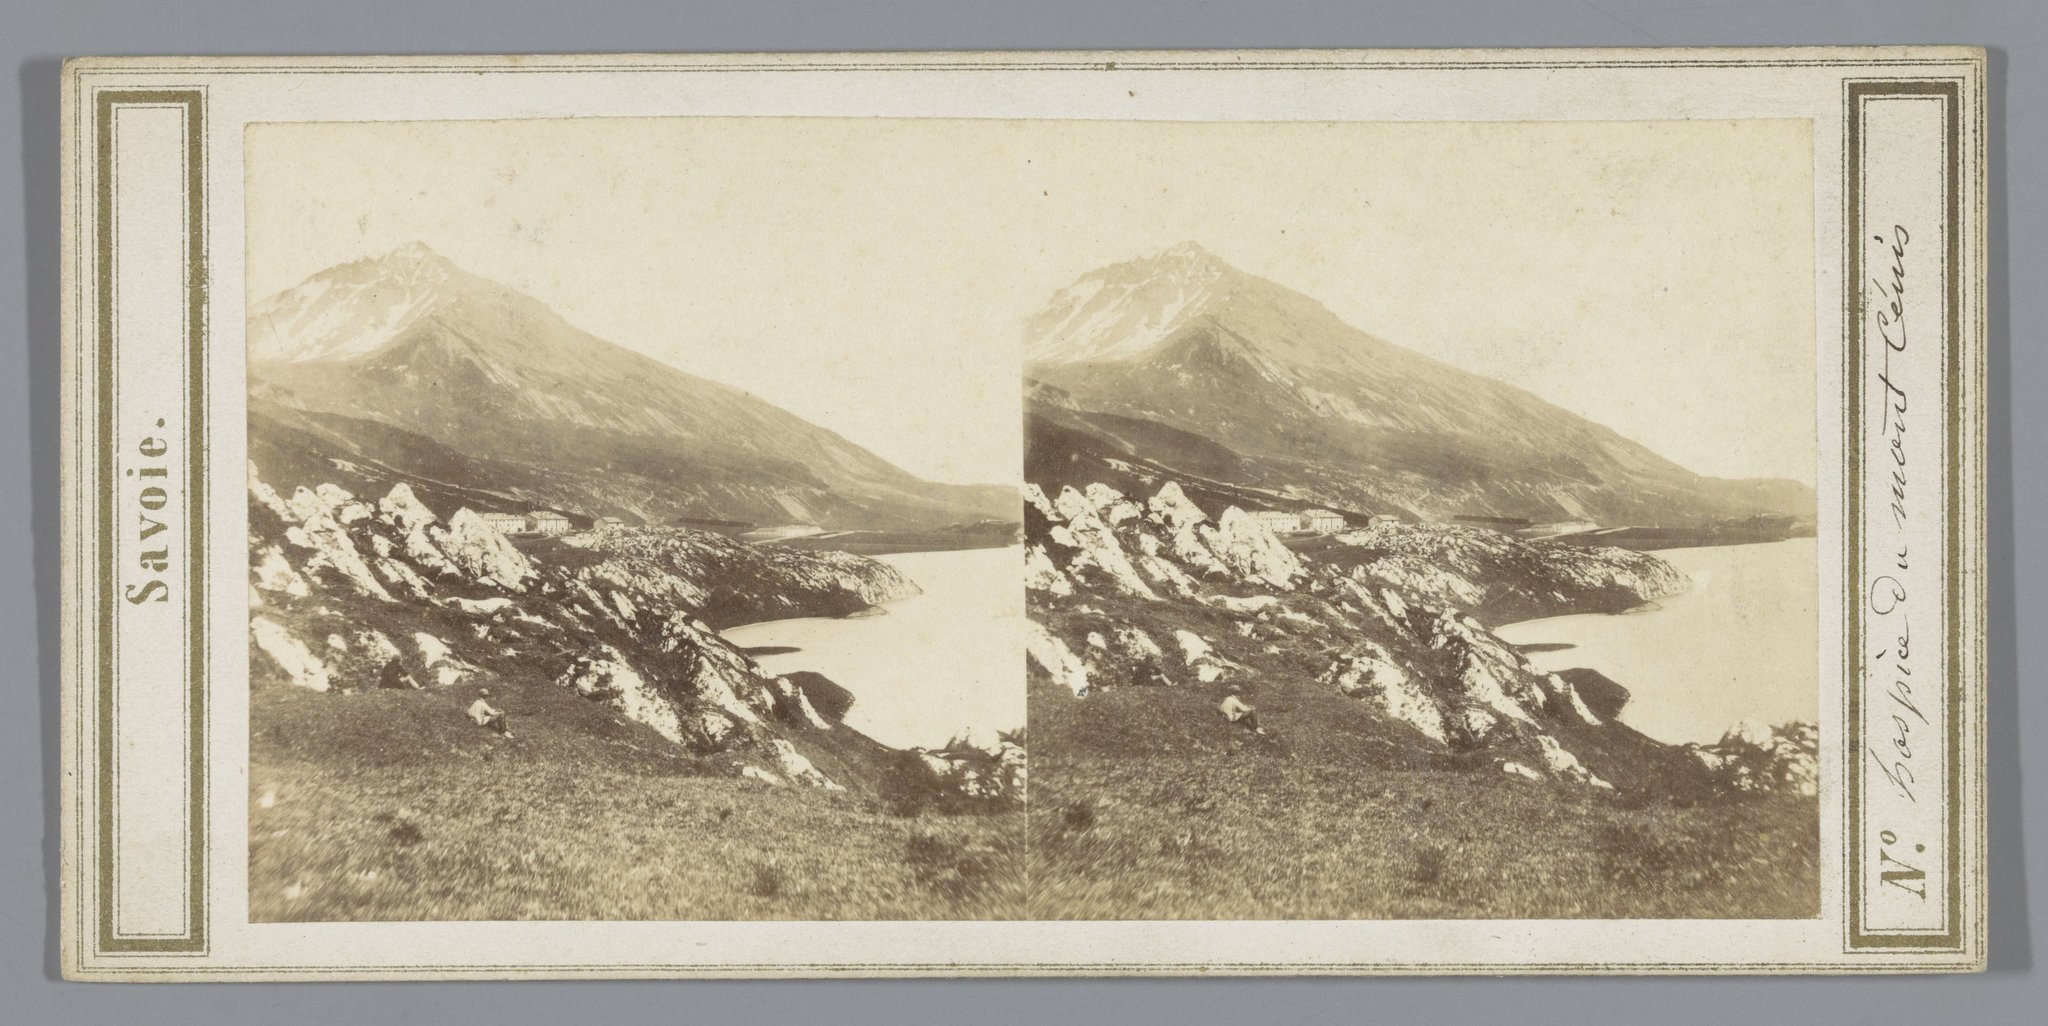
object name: stereograph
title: Hospice op de Mont Cenis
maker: alexandre bertrand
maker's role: fotograaf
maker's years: 1822-1889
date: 1865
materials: cardboard, paper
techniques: albumen print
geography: mont cenis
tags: hospital, mountains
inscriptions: inscription: ‘N4.t./ 23./ 175’